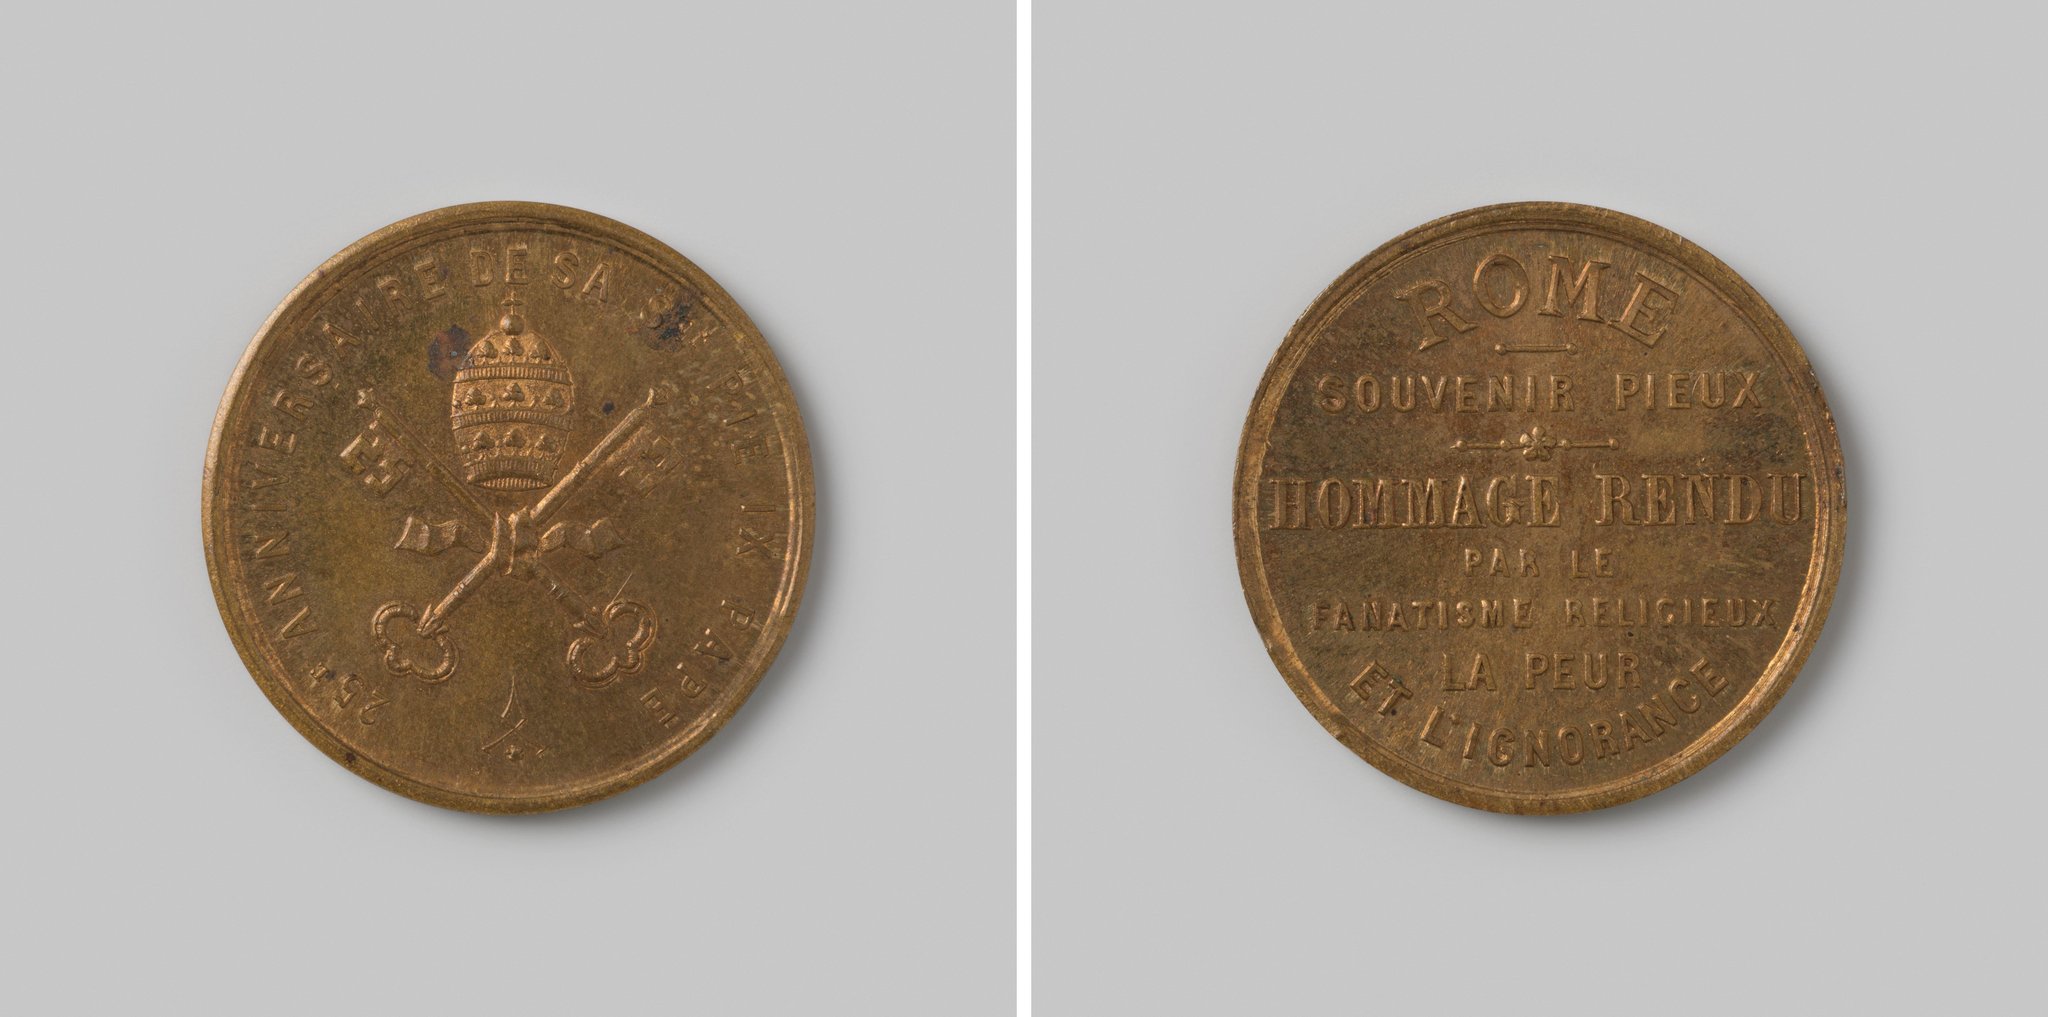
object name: history medal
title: Vijfentwintigjarig ambtsjubileum Paus Pius IX (1871)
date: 1871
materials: brass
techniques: striking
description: Messing penning, op de voorzijde gekruiste sleutels onder een tiara, met omschrift, op de keerzijde zeven regels tekst.